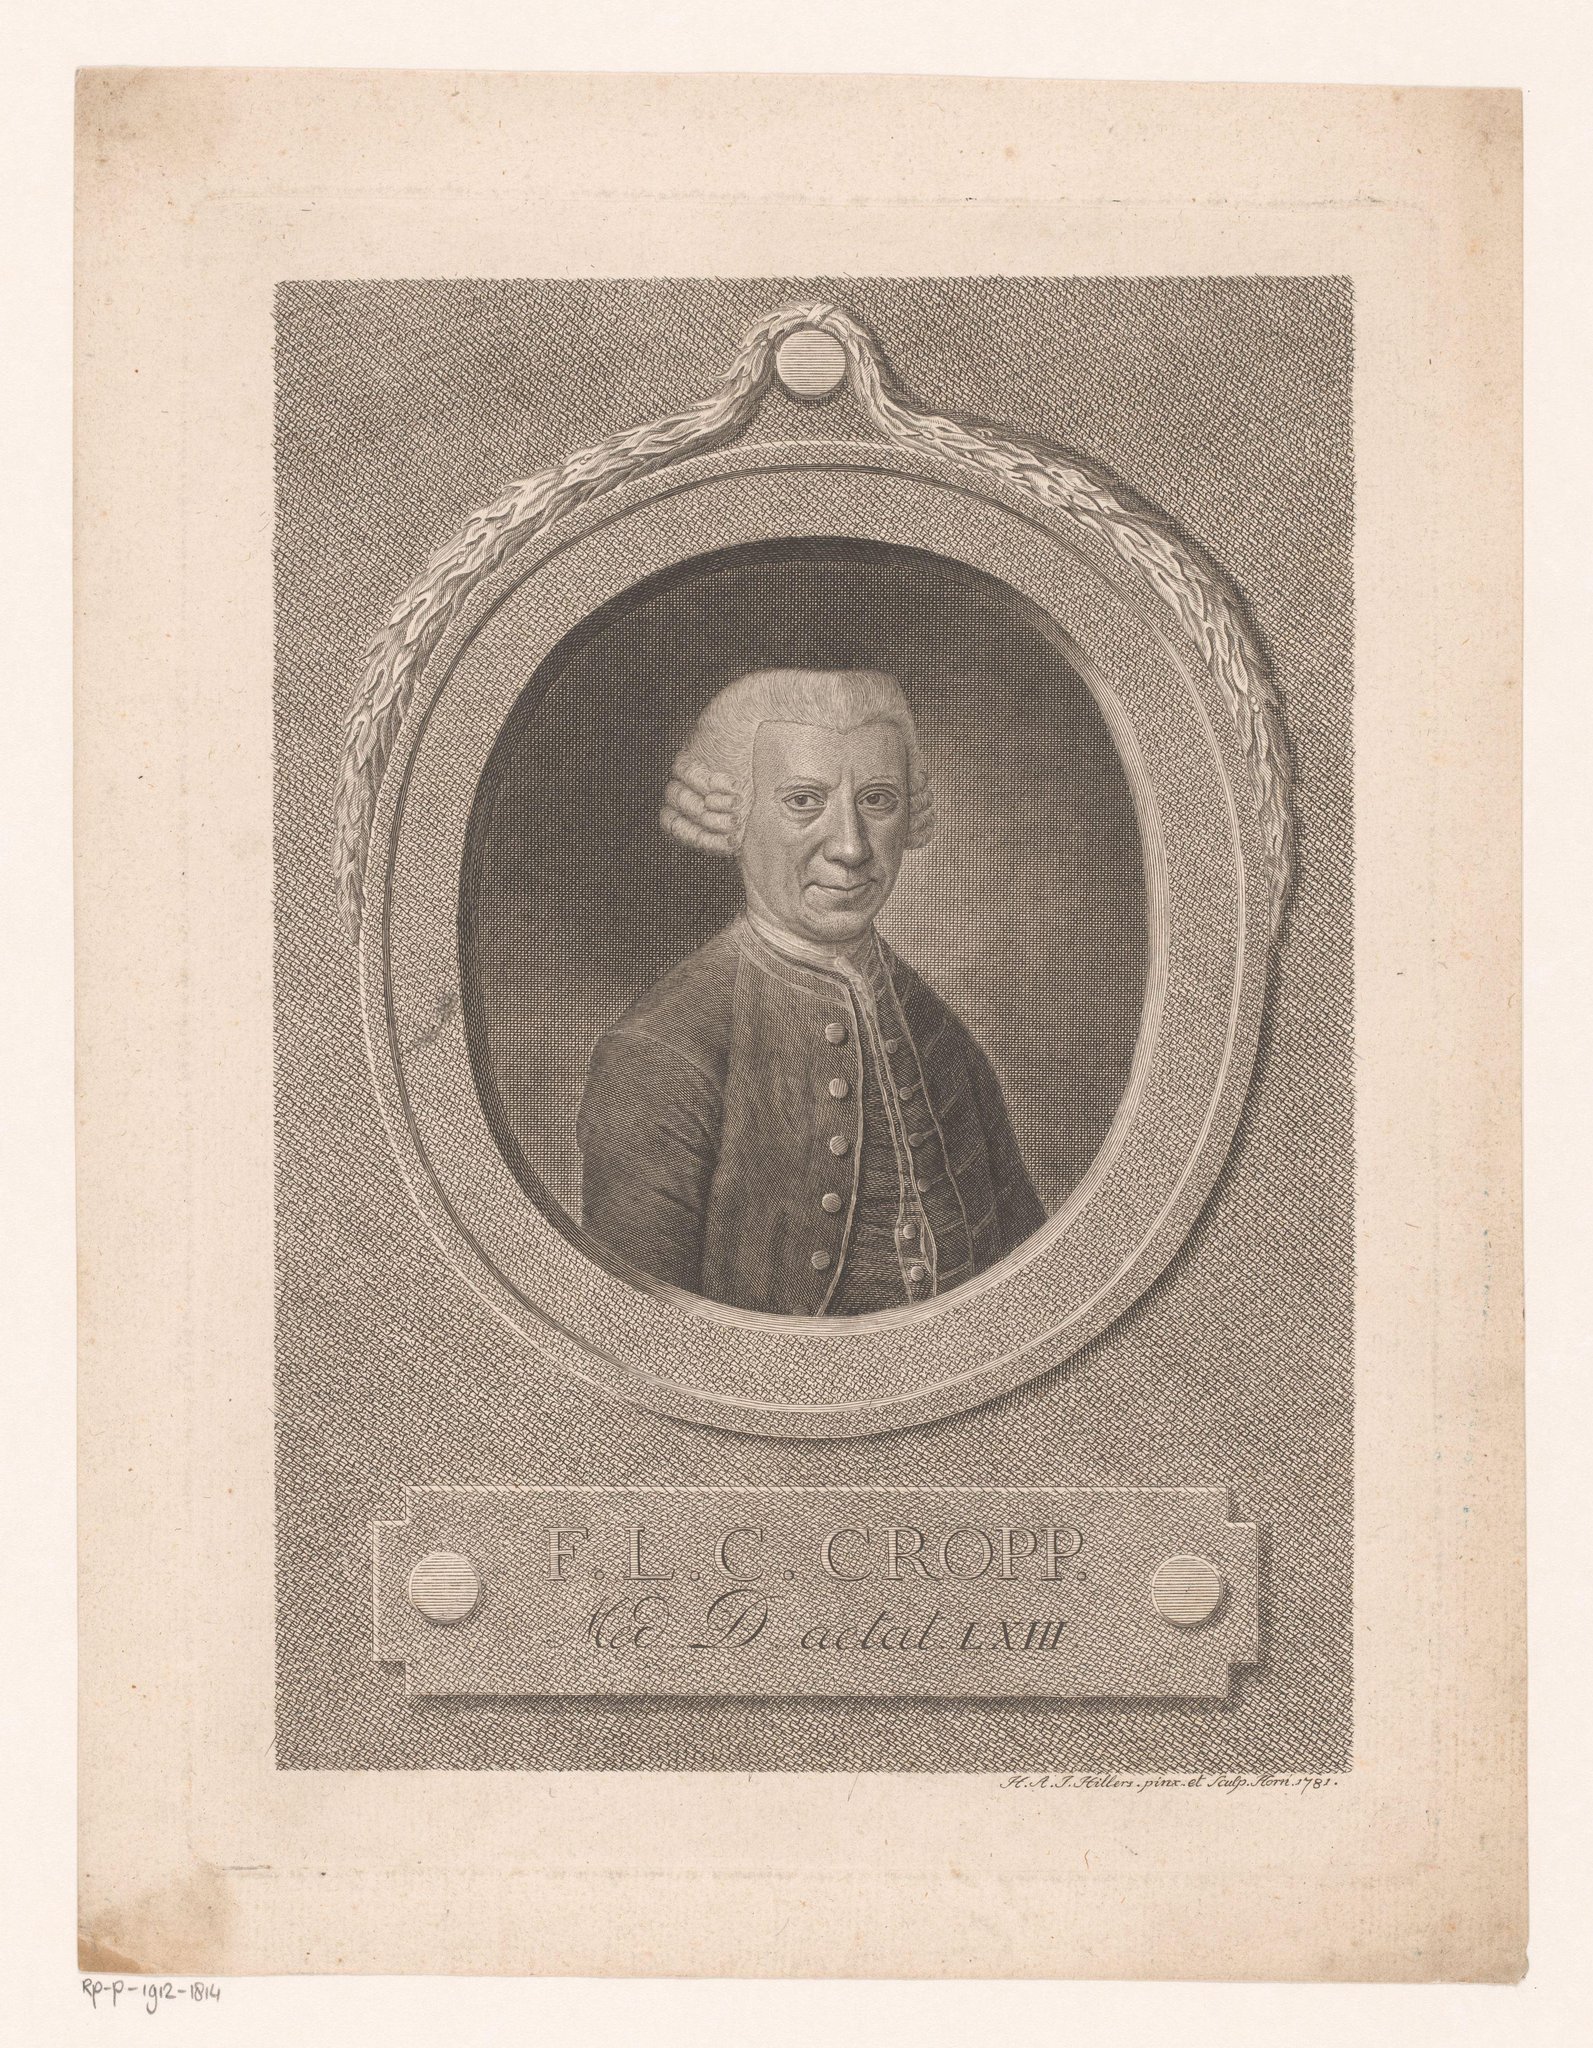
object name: print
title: Portret van Friedrich Ludwig Christian Cropp op 63-jarige leeftijd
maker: hans andreas joachim hillers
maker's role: print maker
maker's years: 1750-1817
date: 1781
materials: paper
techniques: engraving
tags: ornament ~ medallion, historical persons, ornament ~ festoon, garland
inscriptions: collector's mark: Lugt 2228